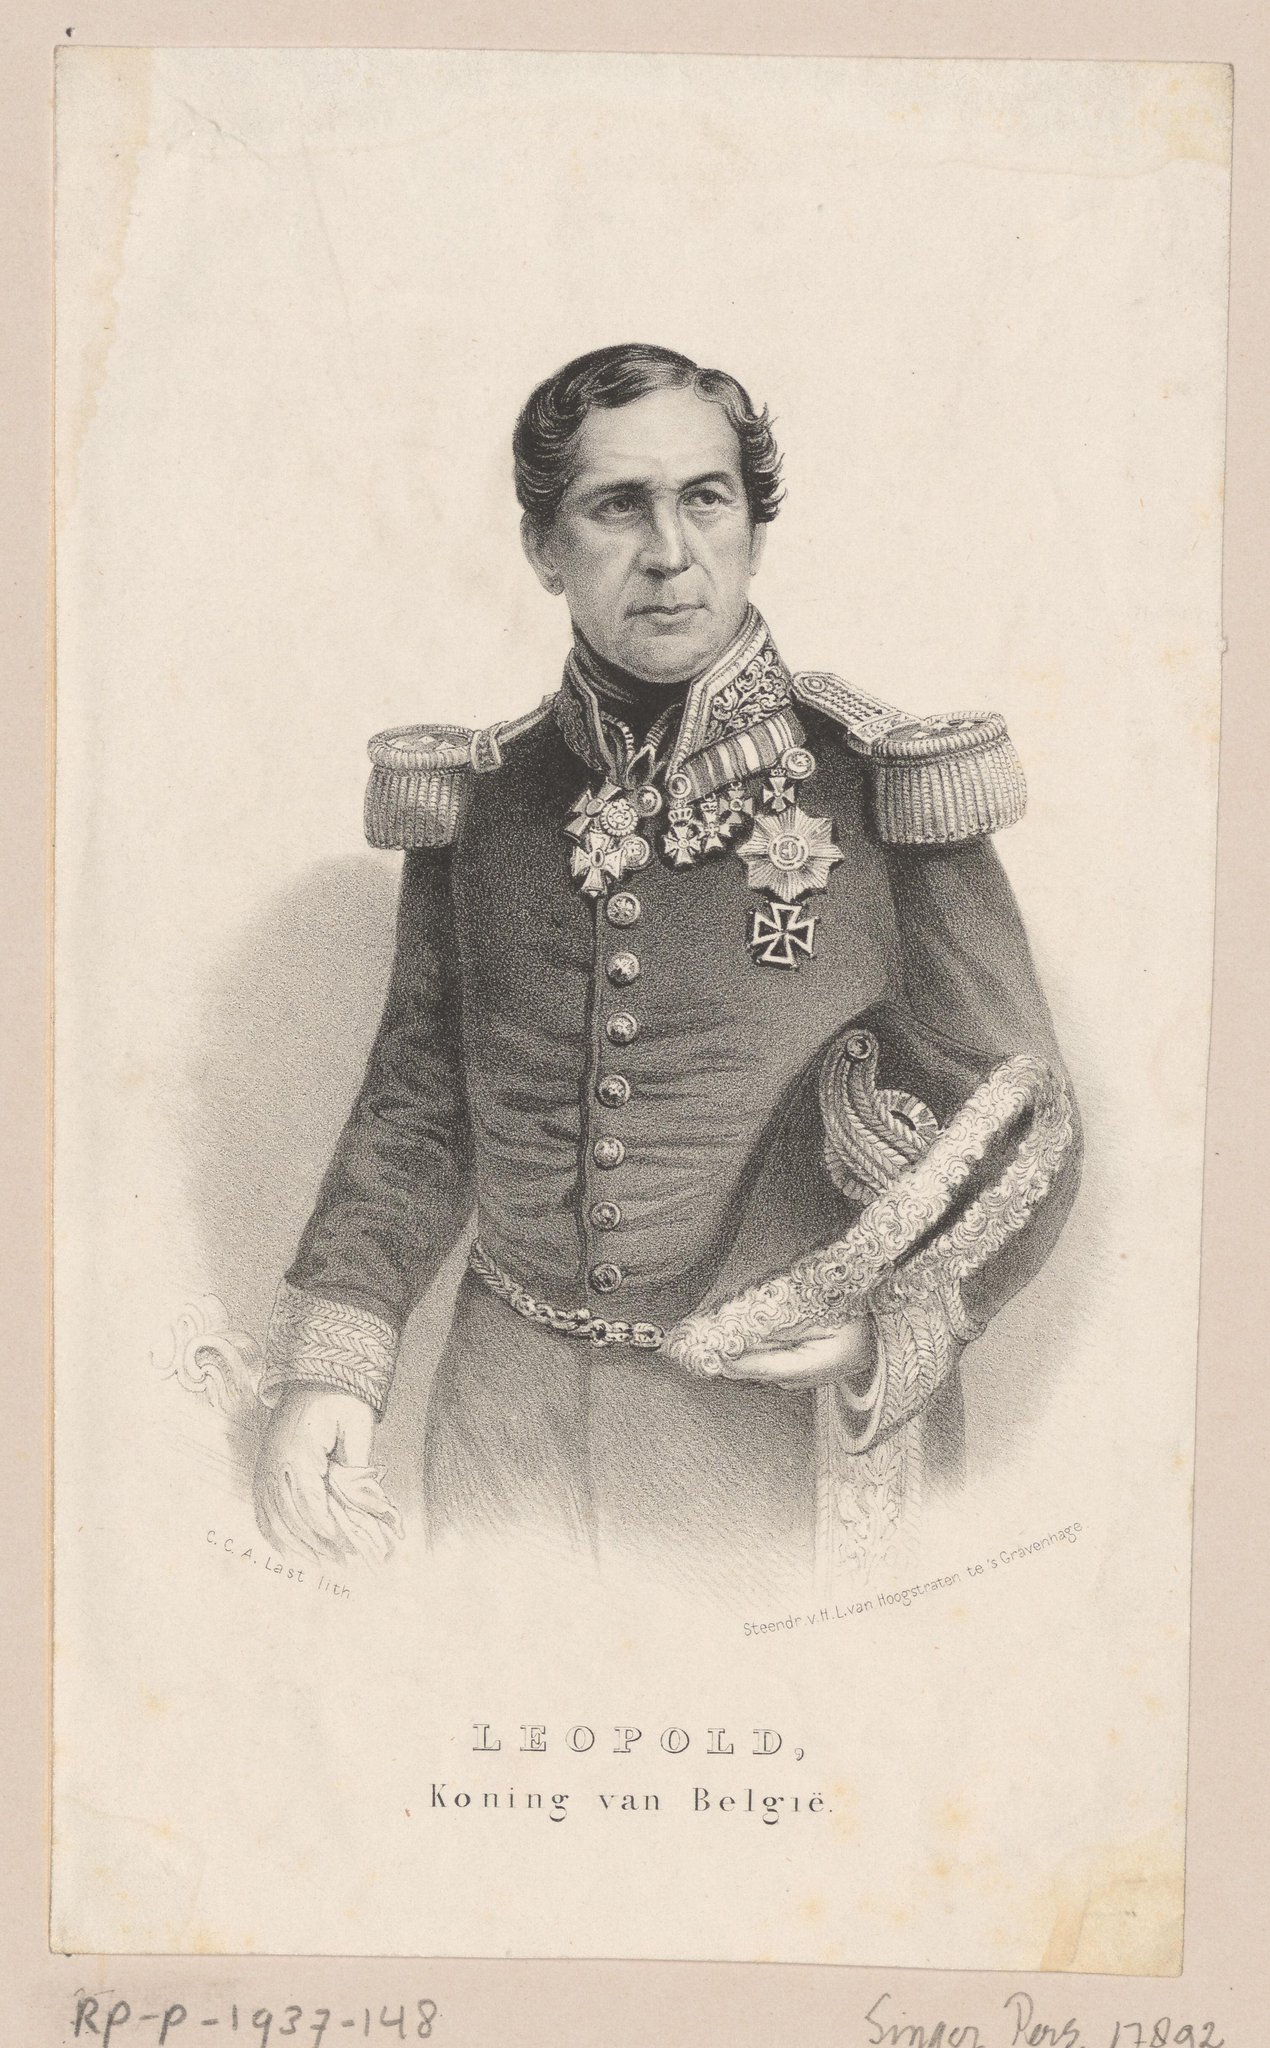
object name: print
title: Portret van Leopold I van België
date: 1859-1865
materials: paper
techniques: lithograph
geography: the hague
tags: laeken, leopold i (koning der belgen), knighthood order, historical persons, (military) uniforms, king